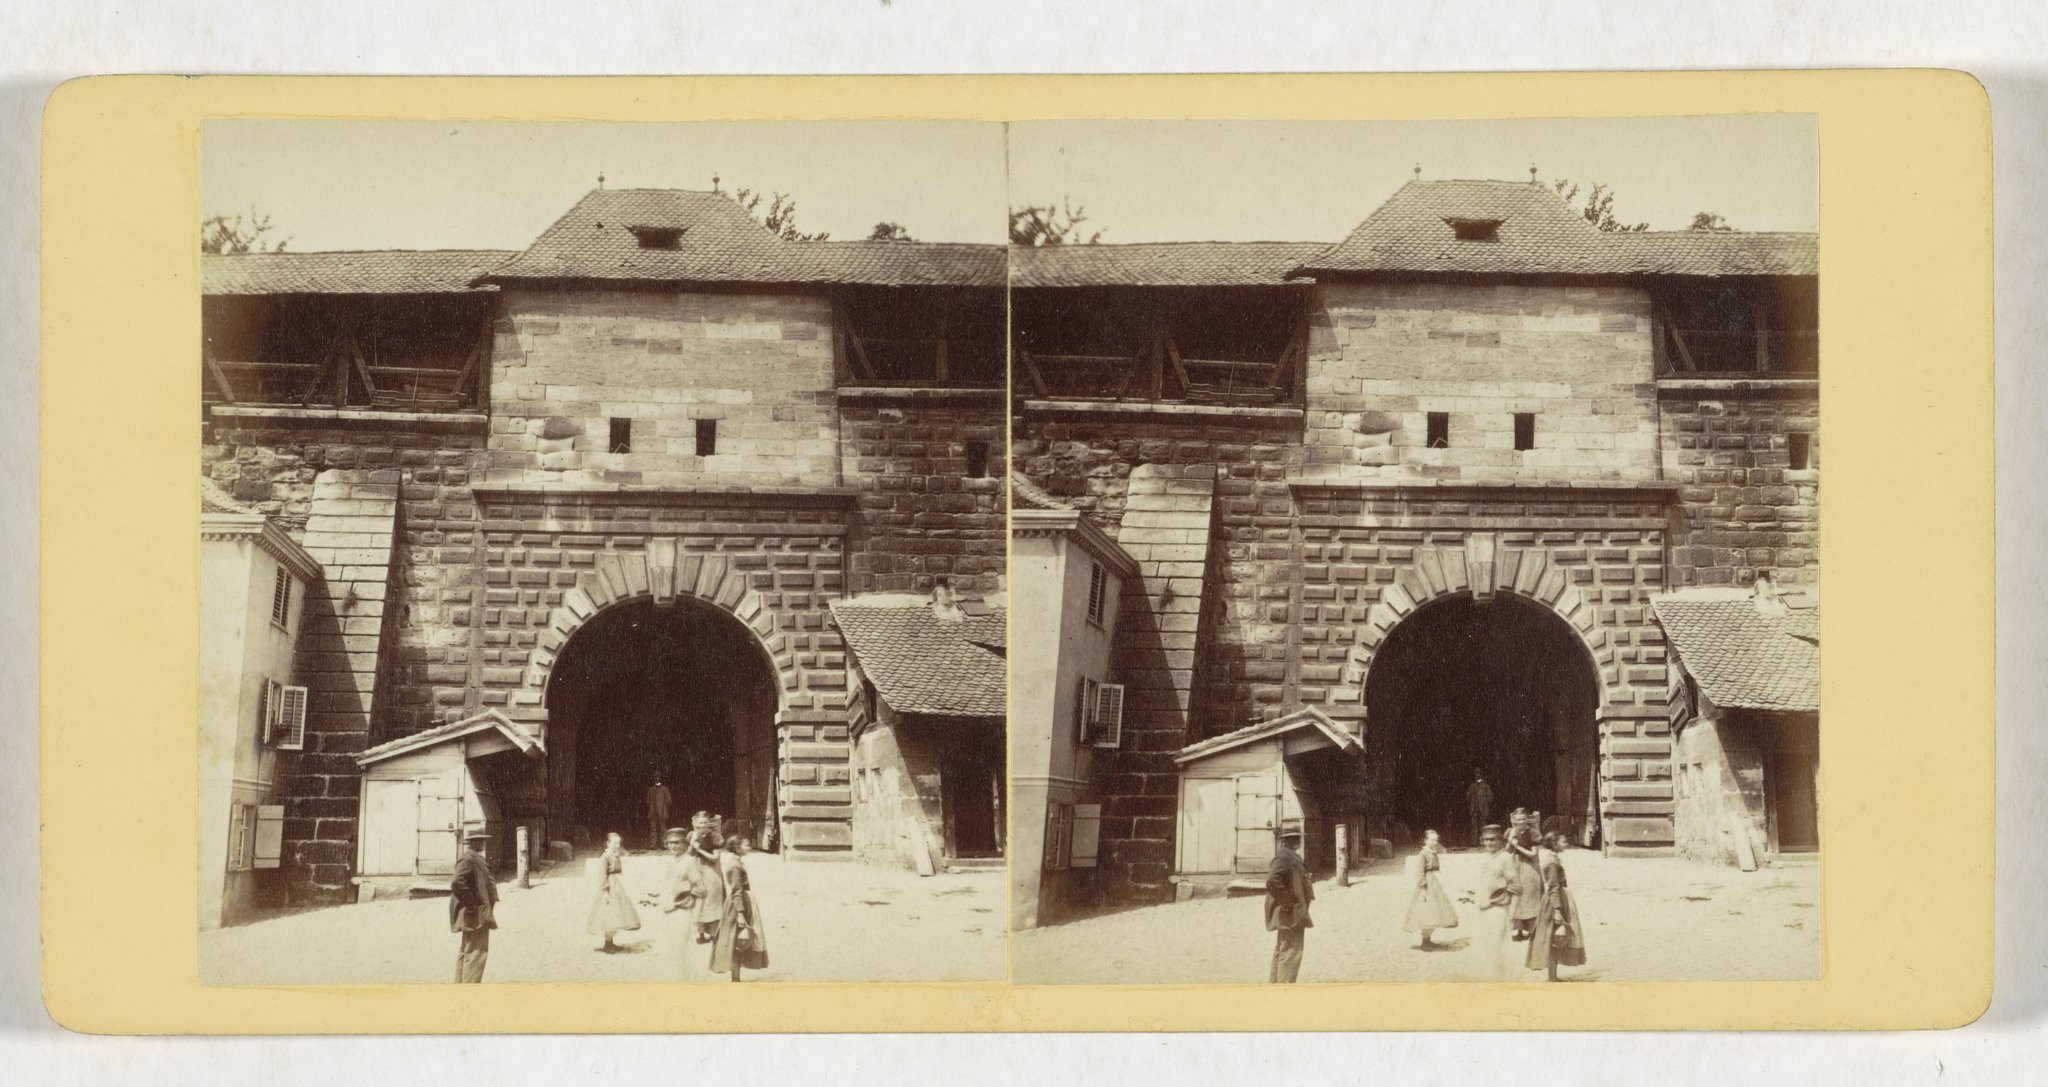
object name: stereograph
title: Thiergärtner Thor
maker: johann friedrich stiehm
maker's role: fotograaf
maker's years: 1826-1902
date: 1868-1888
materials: cardboard, paper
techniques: albumen print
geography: london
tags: gate ~ fortified city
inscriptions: number: ‘No. 22.’